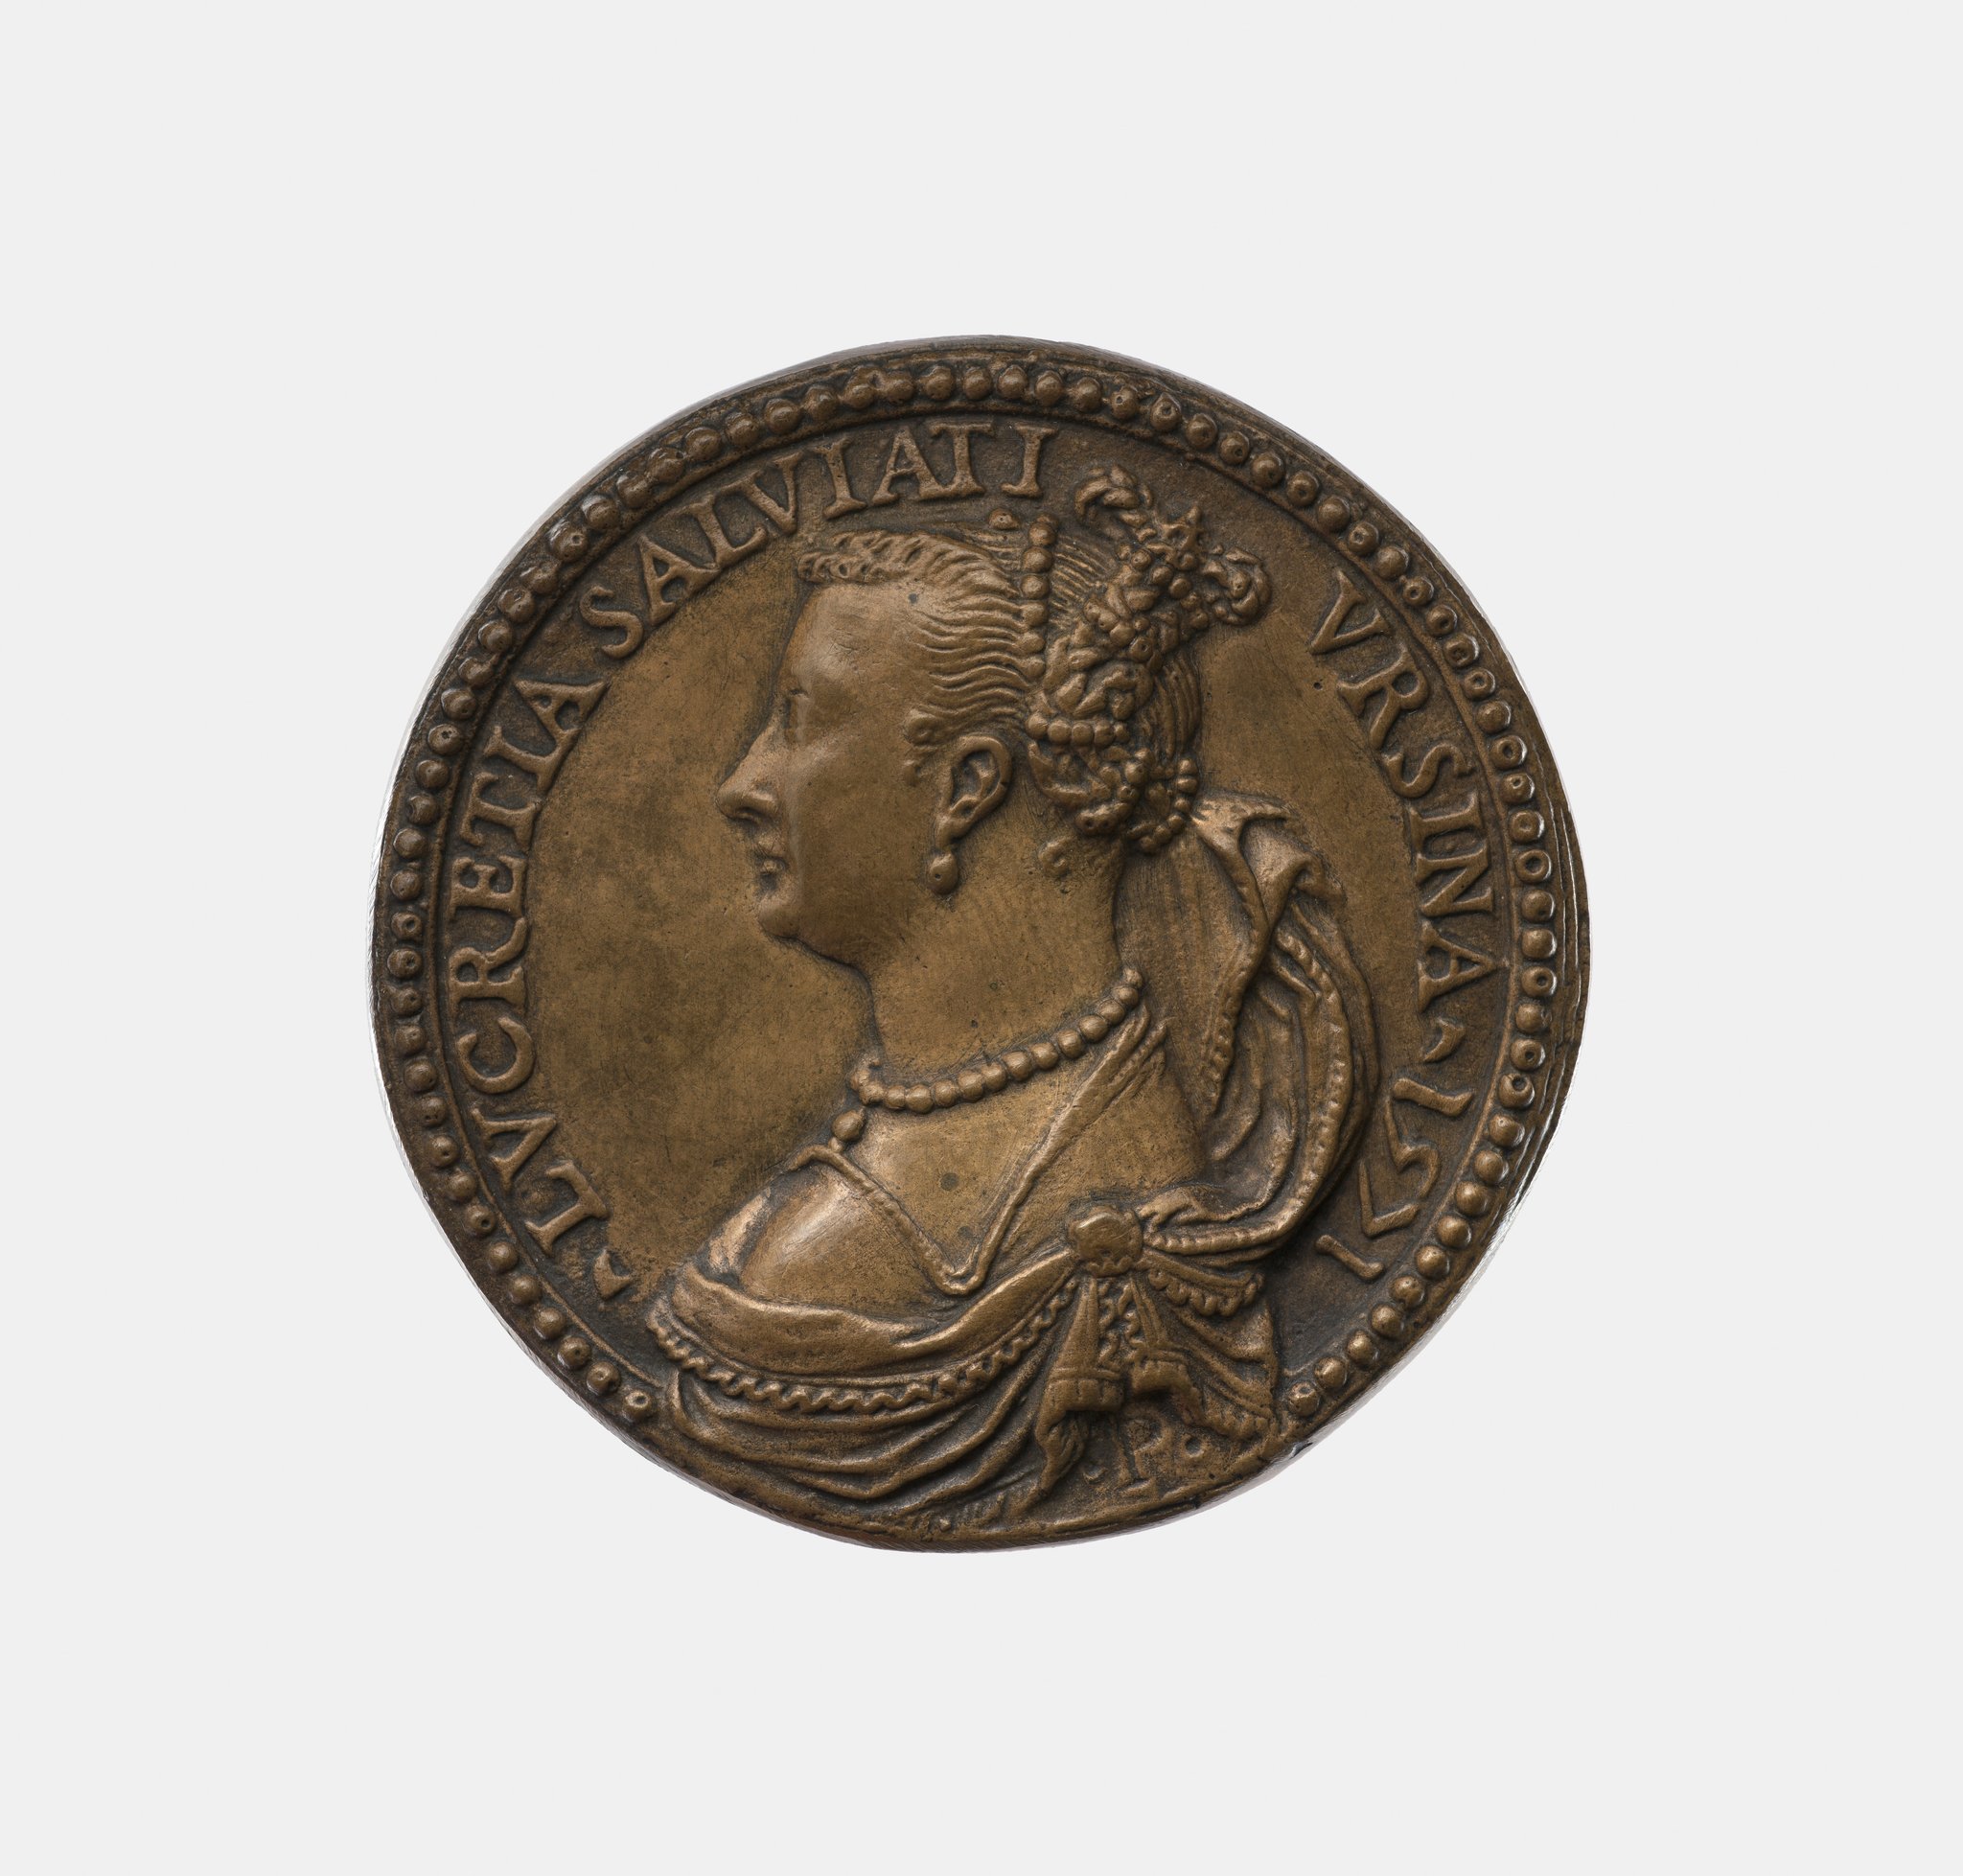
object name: uniface medal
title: Lucretia Salviati Orsini (Ursina)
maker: pastorino de pastorini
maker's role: artist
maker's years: 1508-1592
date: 1571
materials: bronze